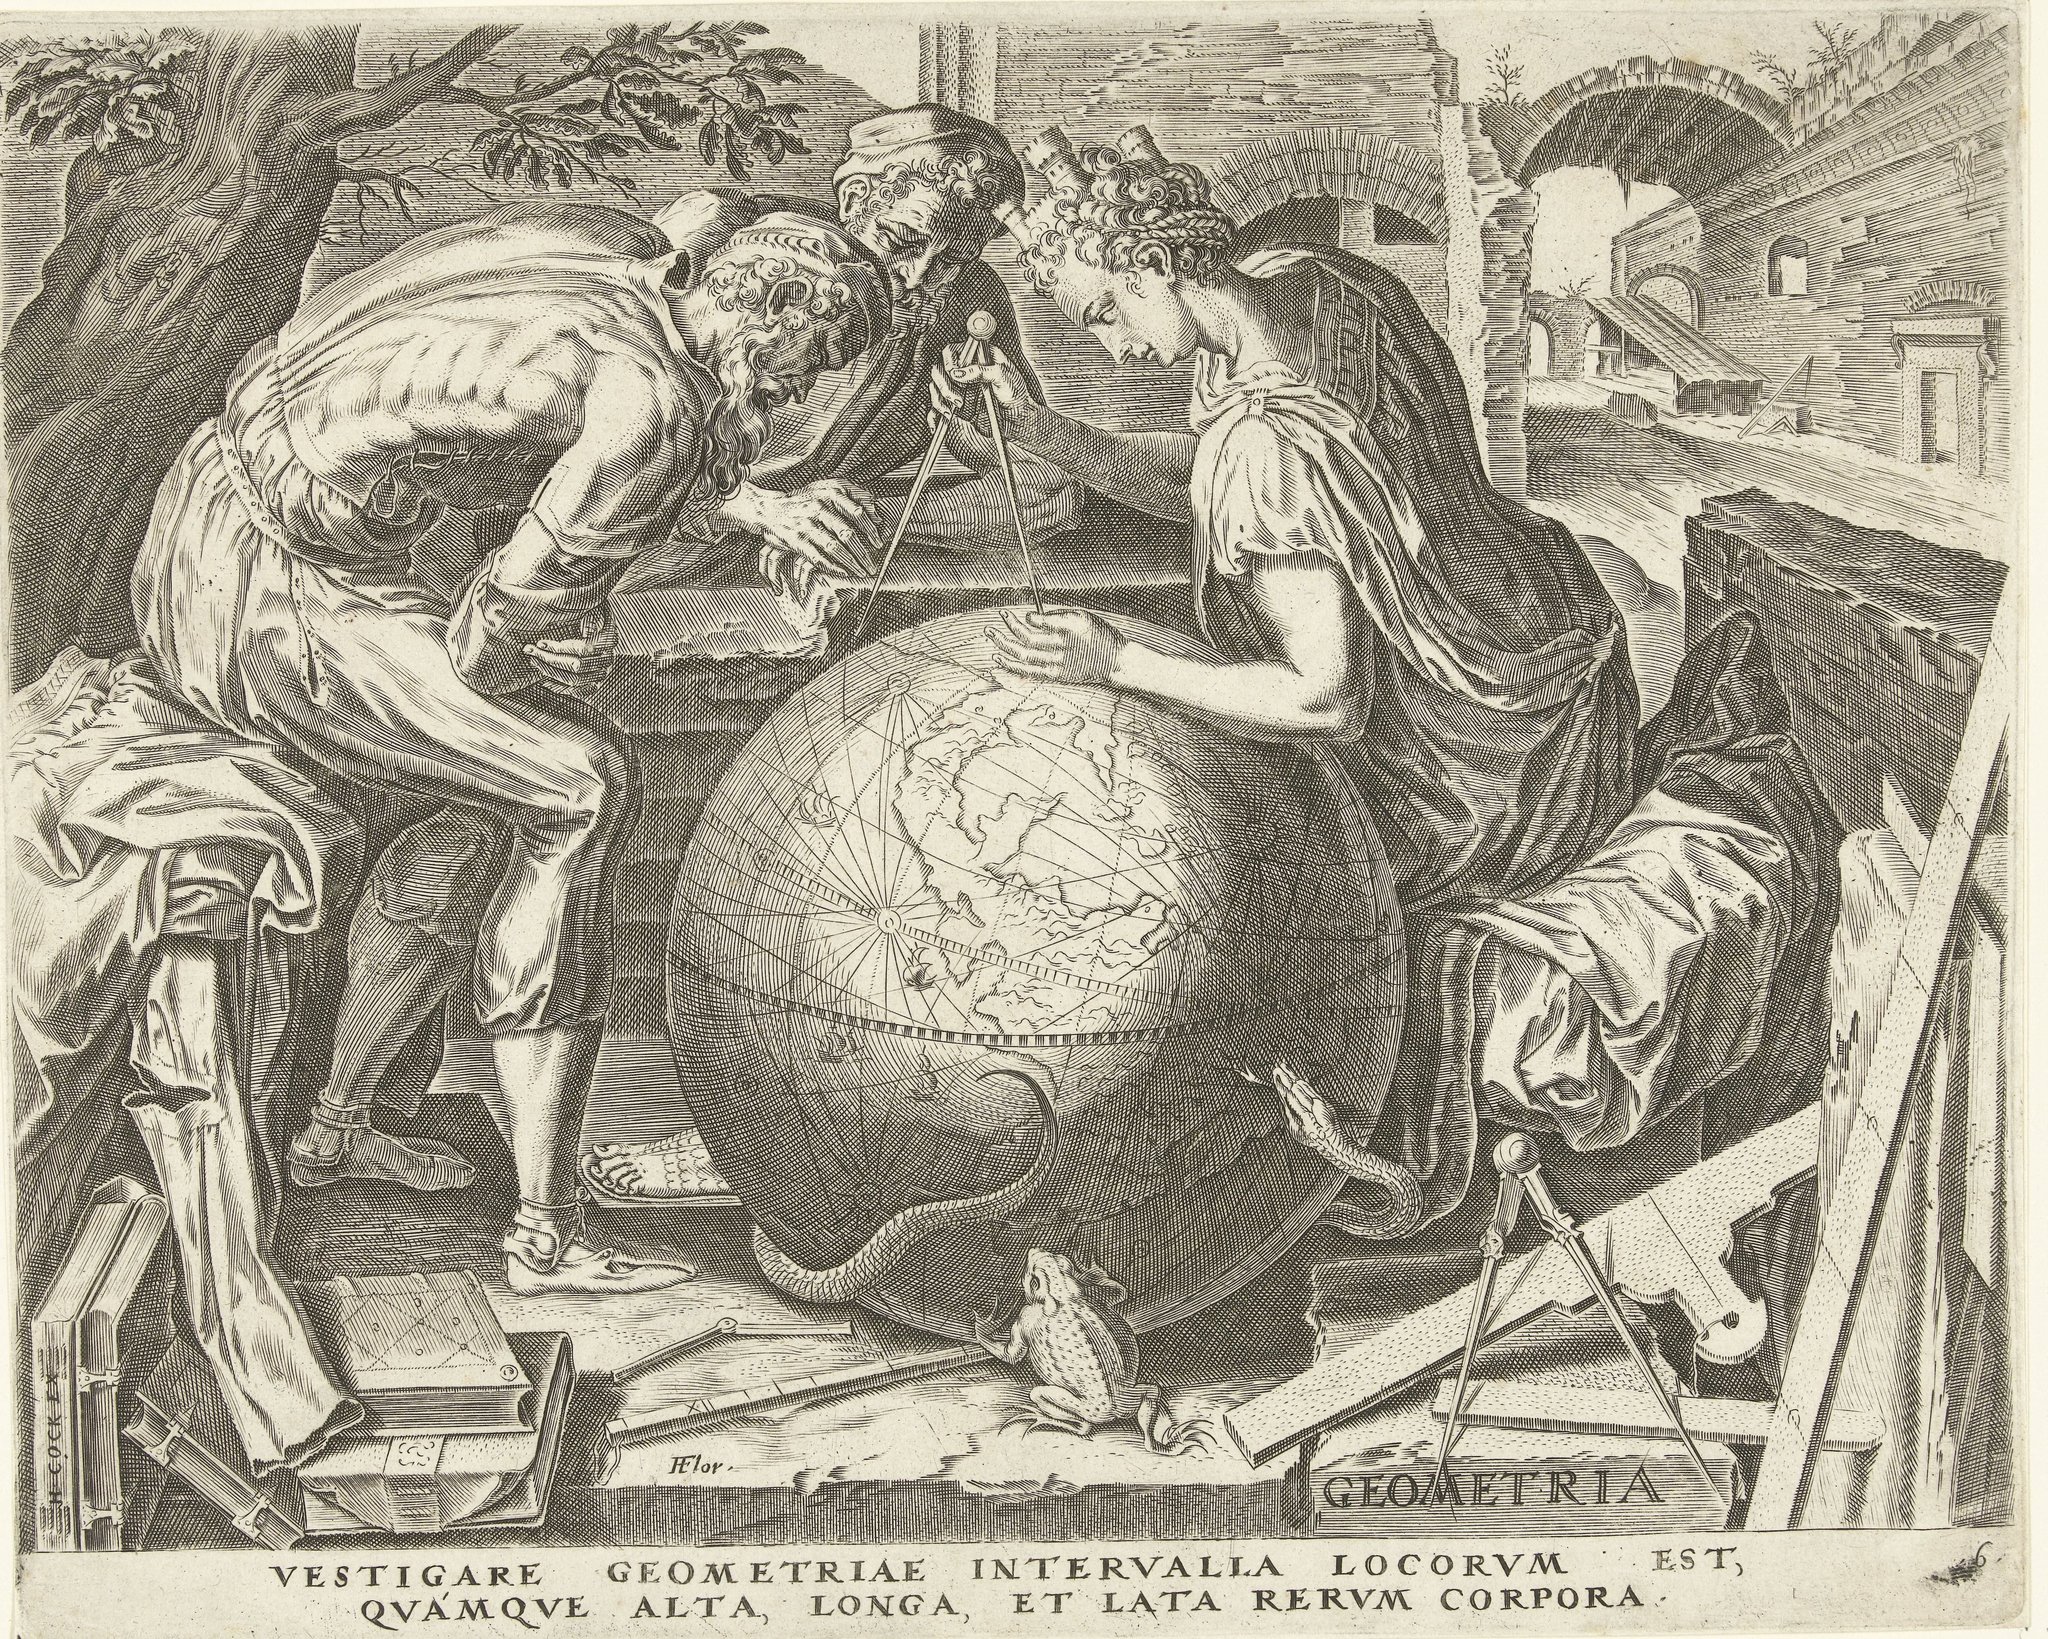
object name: print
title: Geometria (Meetkunde)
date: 1565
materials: paper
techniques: engraving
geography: antwerp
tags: 'geometria' (~ quadrivium); 'geometria' (ripa)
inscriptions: caption:, collector's mark: Lugt 2228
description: Geometria, een vrouw met een stedenkroon op haar hoofd, meet op een globe de afstand tussen twee punten met een passer. Twee mannen kijken met haar mee. Op de grond liggen meetinstrumenten en boeken. Een pad en een slang proberen langs de ronding van de globe omhoog te klimmen. Op de achtergrond ruïnes van antieke gebouwen.